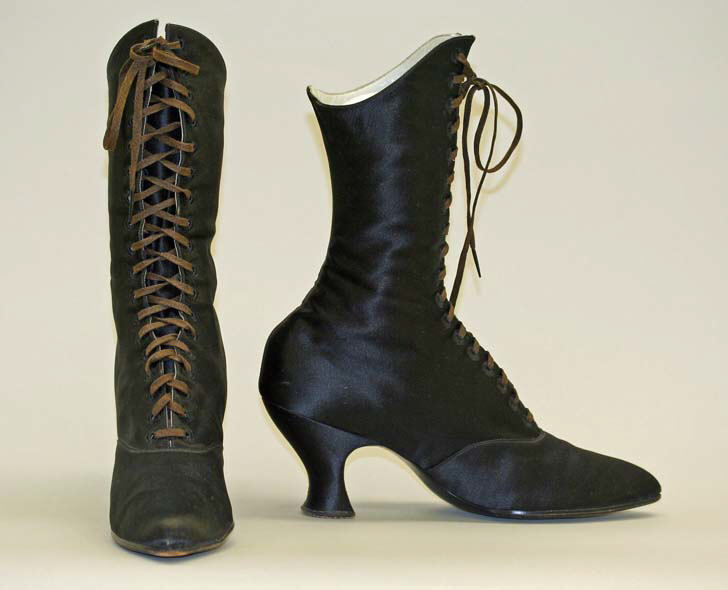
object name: boot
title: Boots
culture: american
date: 1890-1900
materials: silk